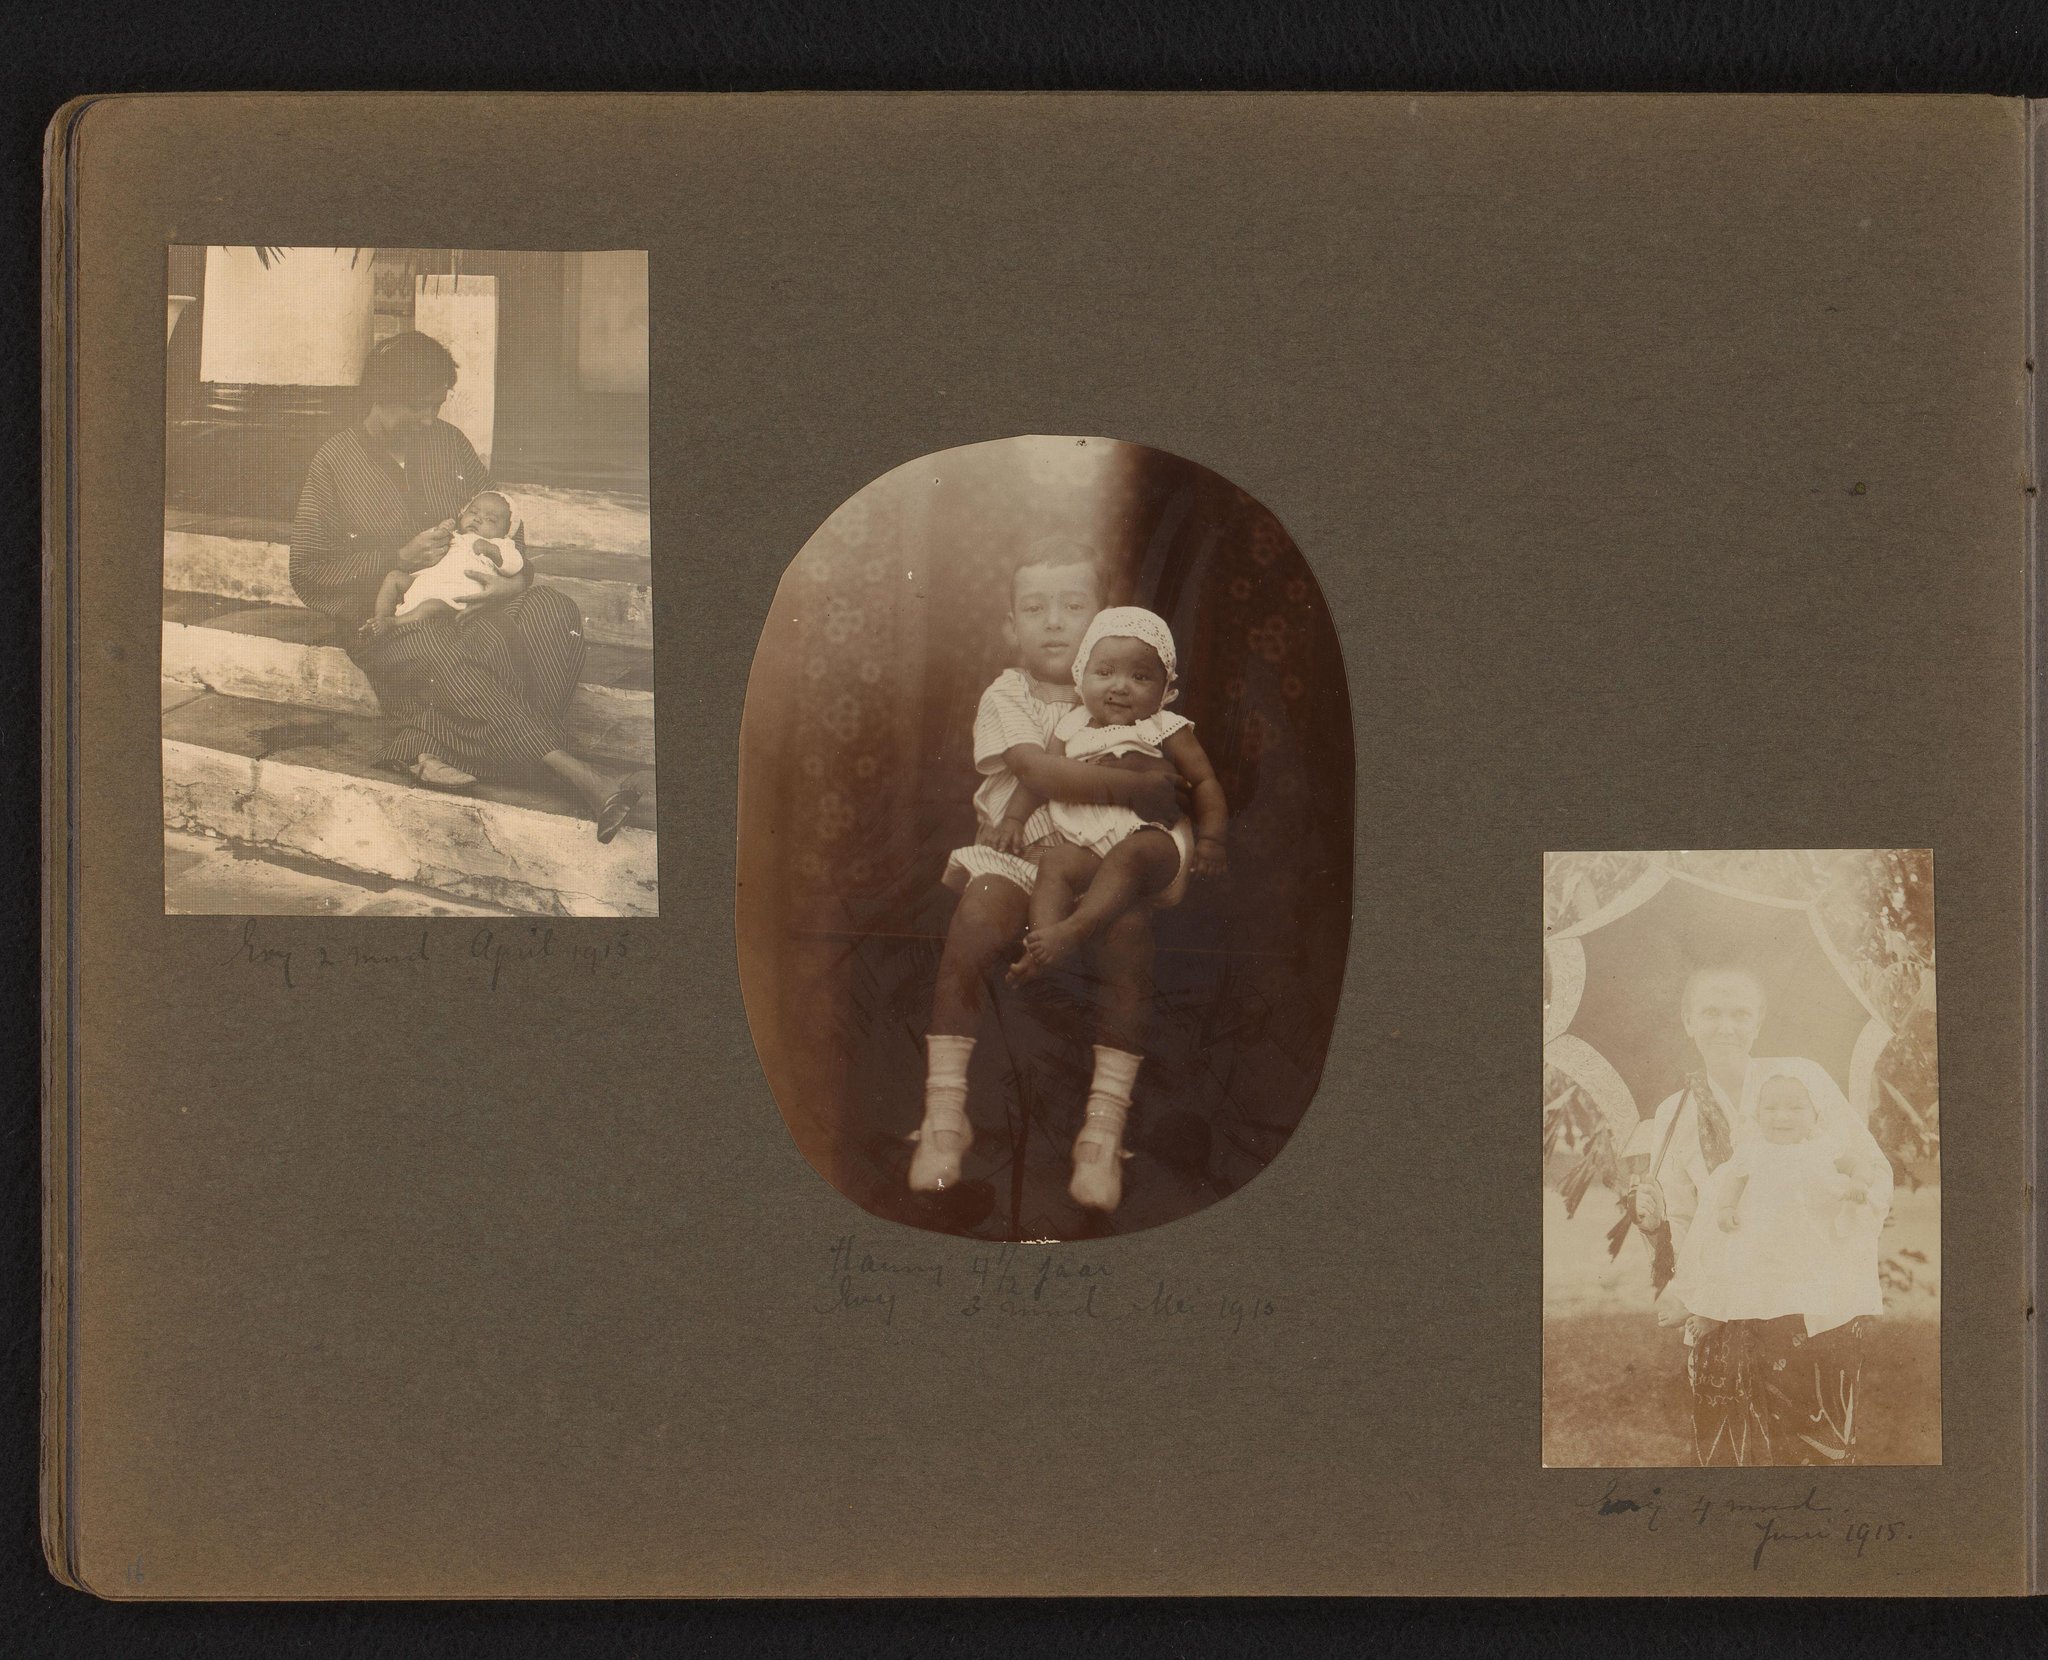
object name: photograph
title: Drie foto's van Eef als baby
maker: frédéric gabriël dumas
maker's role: engineer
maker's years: 1886-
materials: cardboard, photographic support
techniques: gelatin silver print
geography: dutch east indies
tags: surabaya, beatrice jacqueline eveline dumas, java, baby-sitter, female infant, family life at home, infant, baby, dutch east indies, the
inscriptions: annotation: ‘Evy 2 mnd April 1915 / Hanny 4½ jaar / Evy 3 mnd Mei 1915 / Evy 4 mnd Juni 1915.’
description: Blad met drie foto's van Eef Dumas als baby met haar moeder, broer Han en Indonesische kinderverzorgster (destijds 'baboe' genoemd). Onderdeel van het fotoalbum over de kindertijd van Han (geboren sept-okt 1910) en Eef Dumas (geboren februari 1915) in Indië.